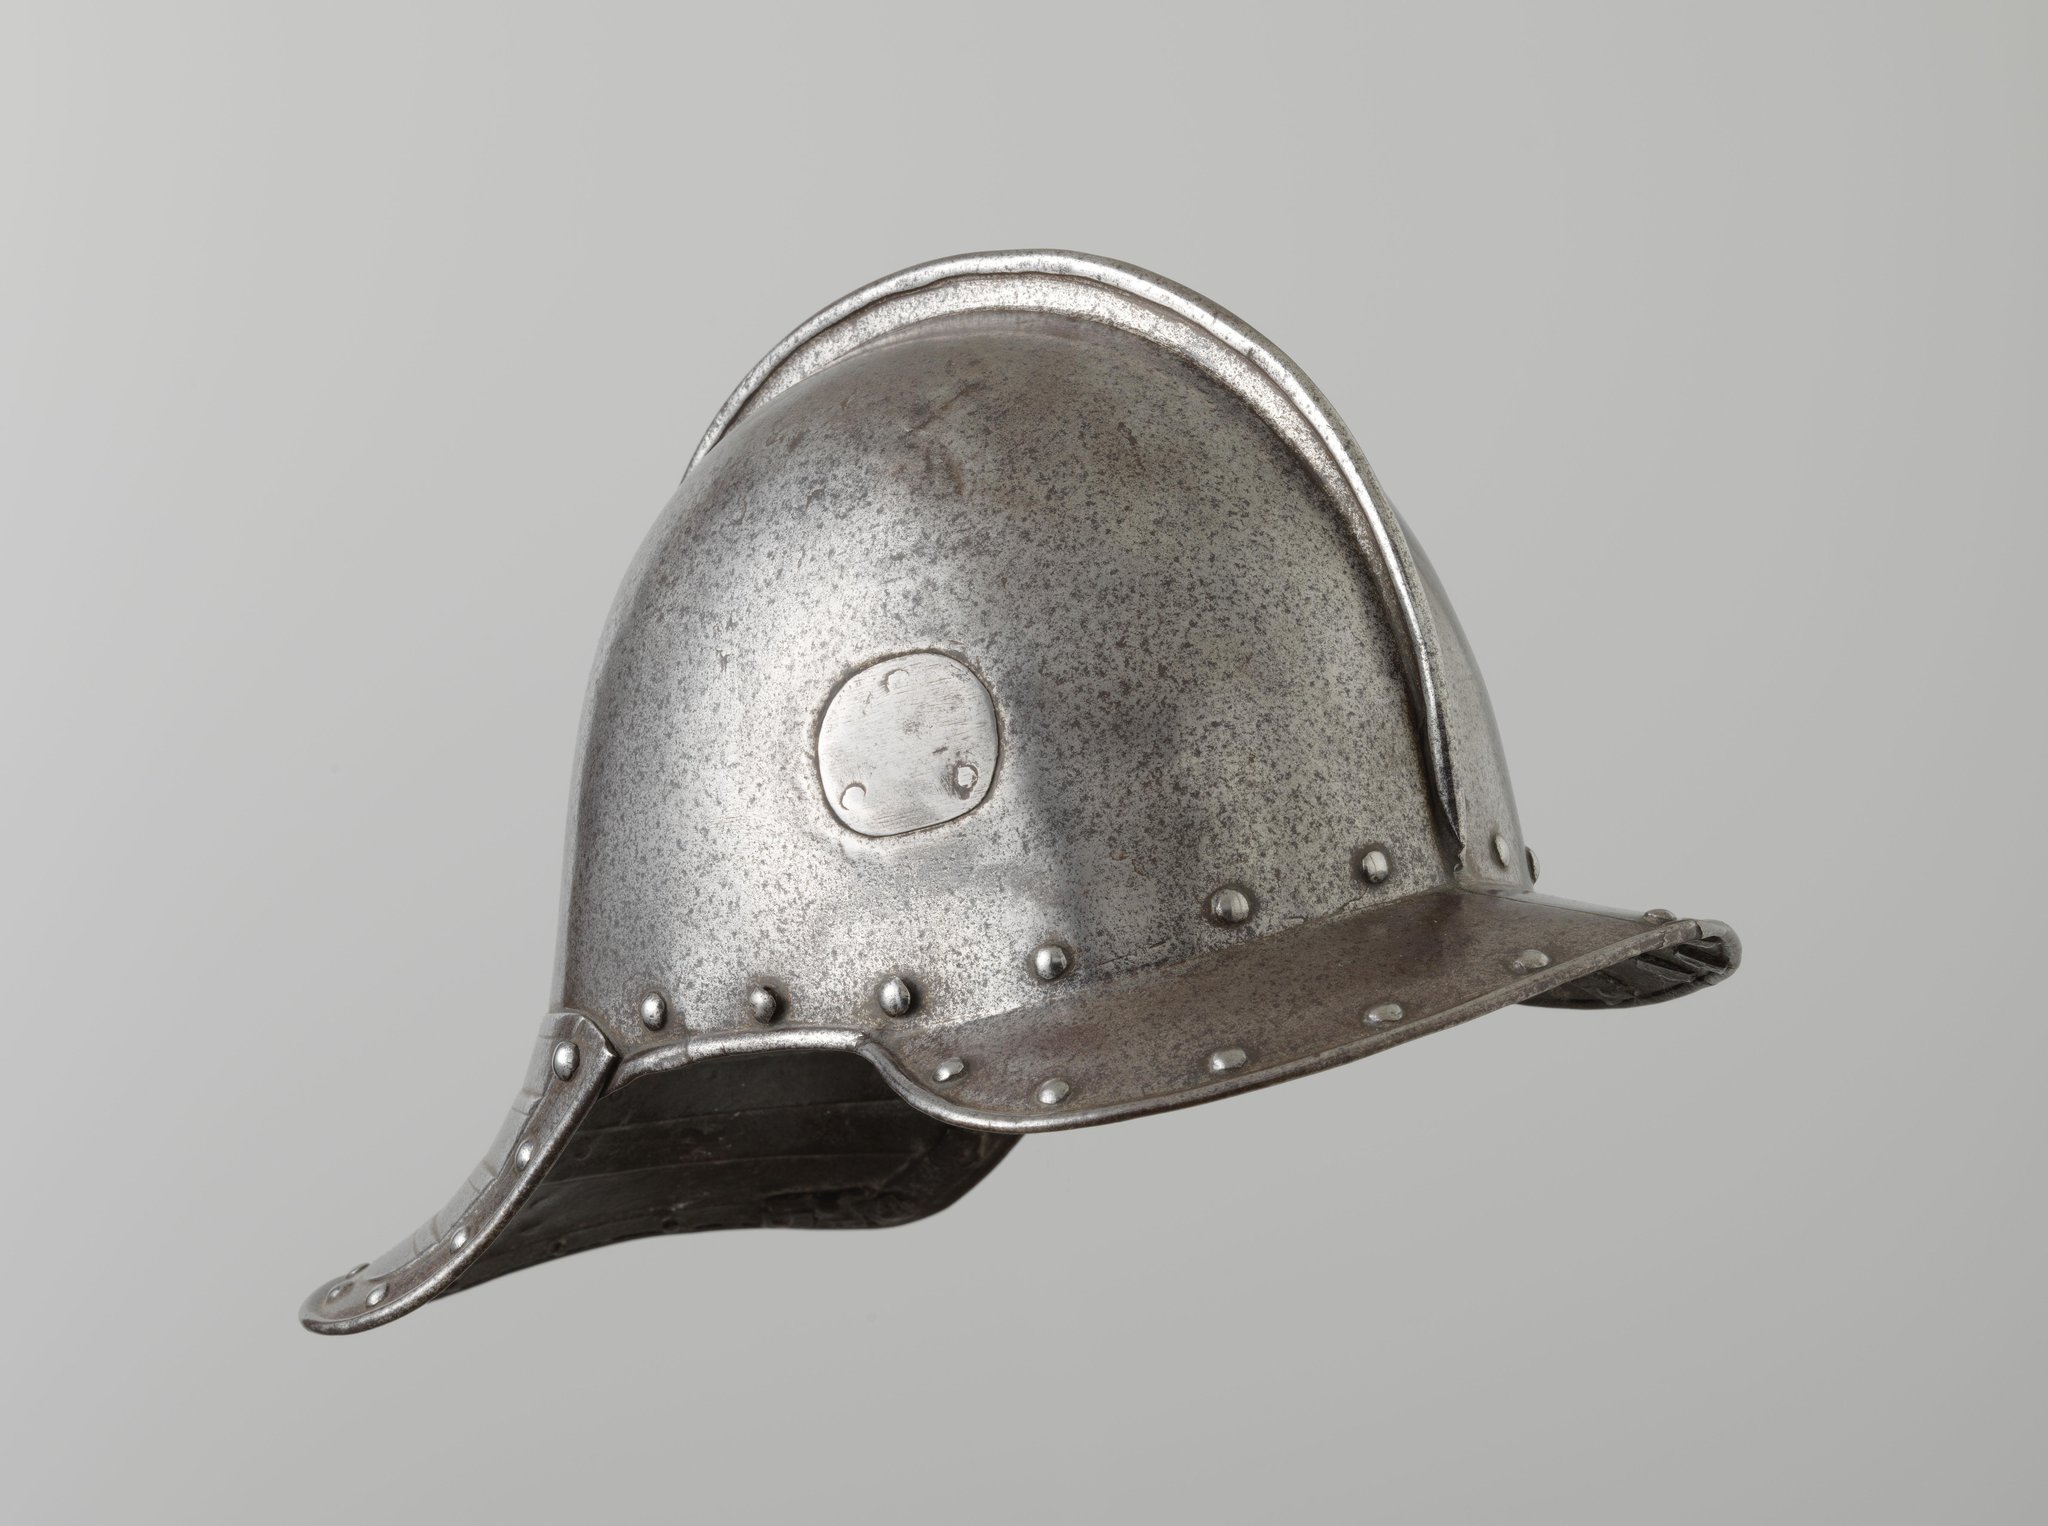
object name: helmet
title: Helm met nekbedekking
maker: Anonymous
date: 1599-1699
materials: iron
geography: low countries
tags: low countries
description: Ruiterhelm, zgn. bourgondische kap. Ronde bal met lage kam, oogklep, gearticuleerde nekbedekking, blank met ijzeren klinksels. Aan het achterhoofd voorzien van pluimhouder. Einde 16de eeuw.